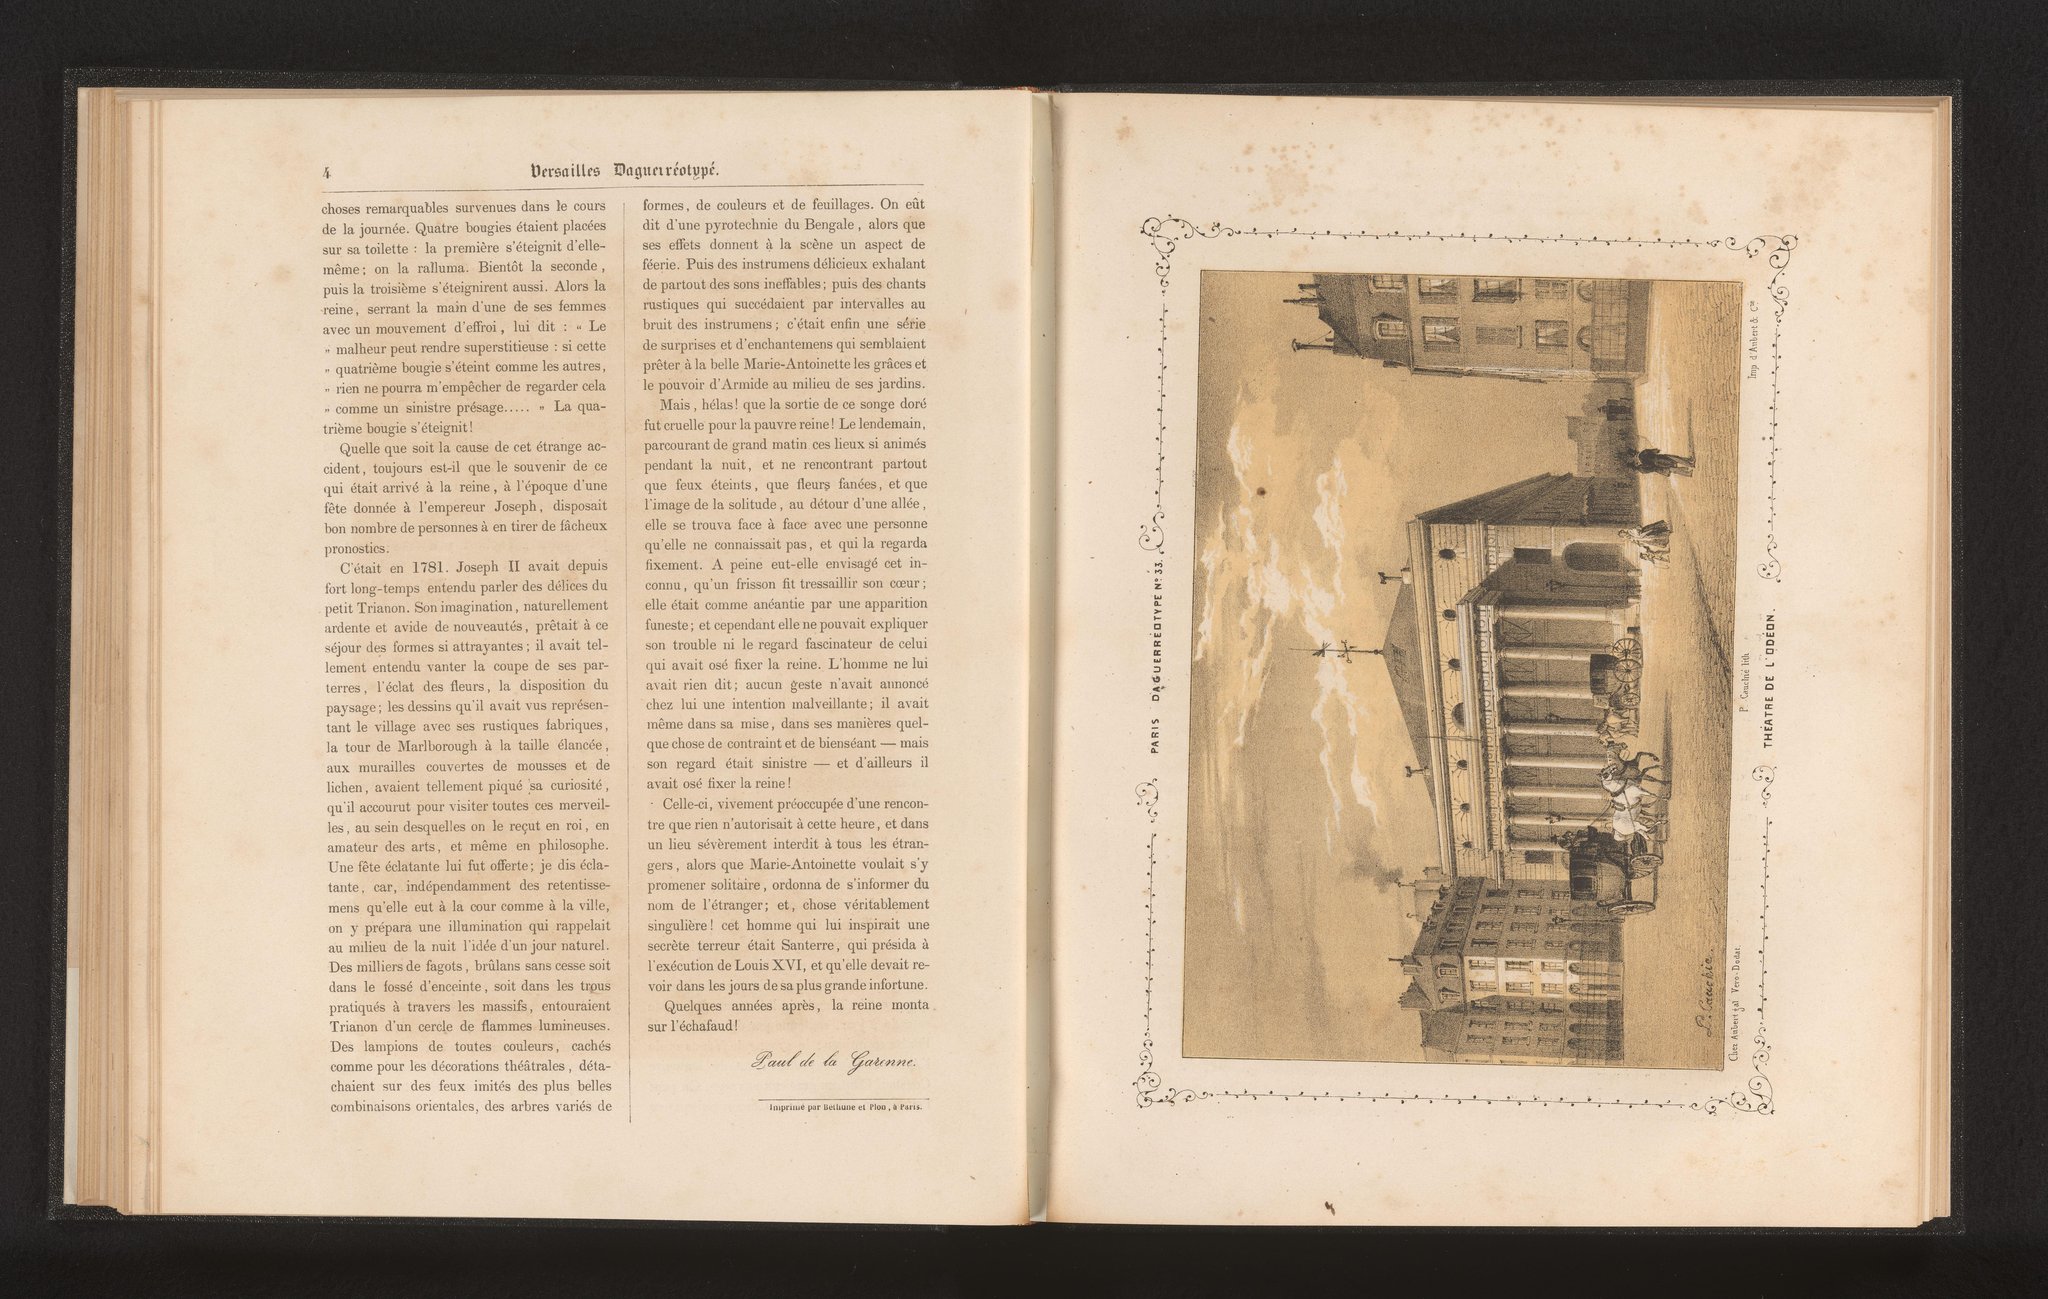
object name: page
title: Théâtre de l'Odéon in Parijs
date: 1839-1840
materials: paper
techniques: tone lithography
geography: paris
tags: theatre (building)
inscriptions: inscription: ‘PARIS DAGUERRÉOTYPÉ No. 33.’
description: Prent op honderdeenendertigste ongenummerde pagina.